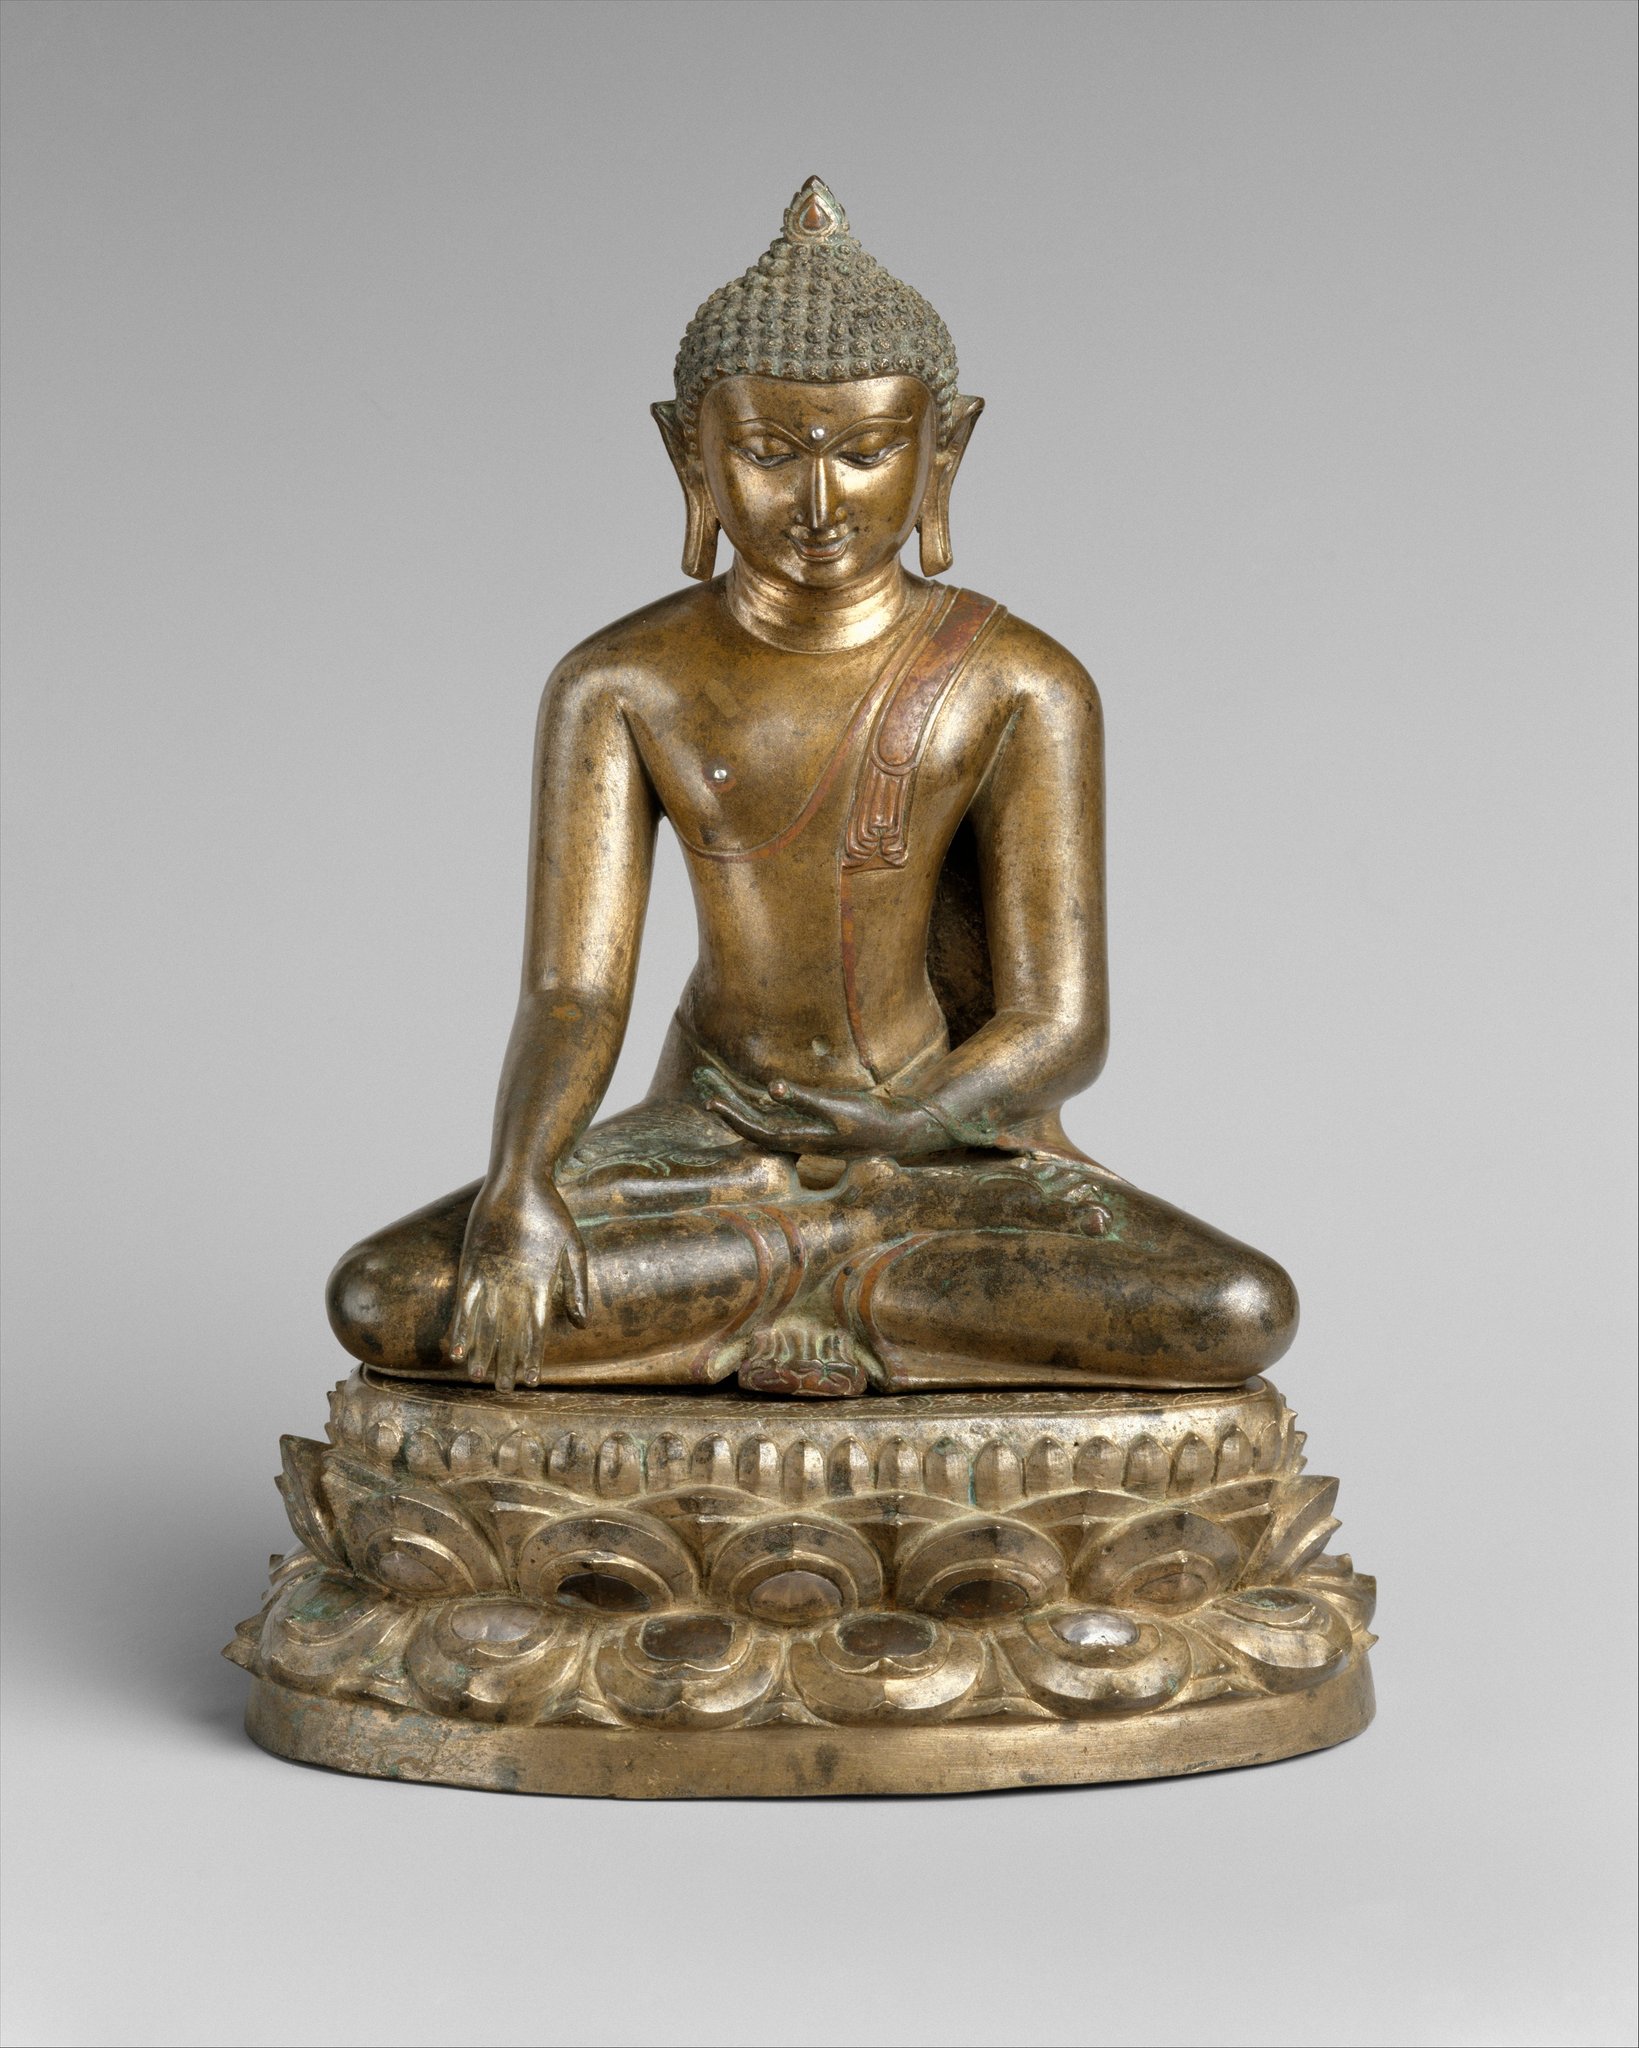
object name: figure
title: Seated Buddha with Double-Lotus Base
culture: burmese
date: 1067-1100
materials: bronze, copper, silver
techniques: inlay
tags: buddha